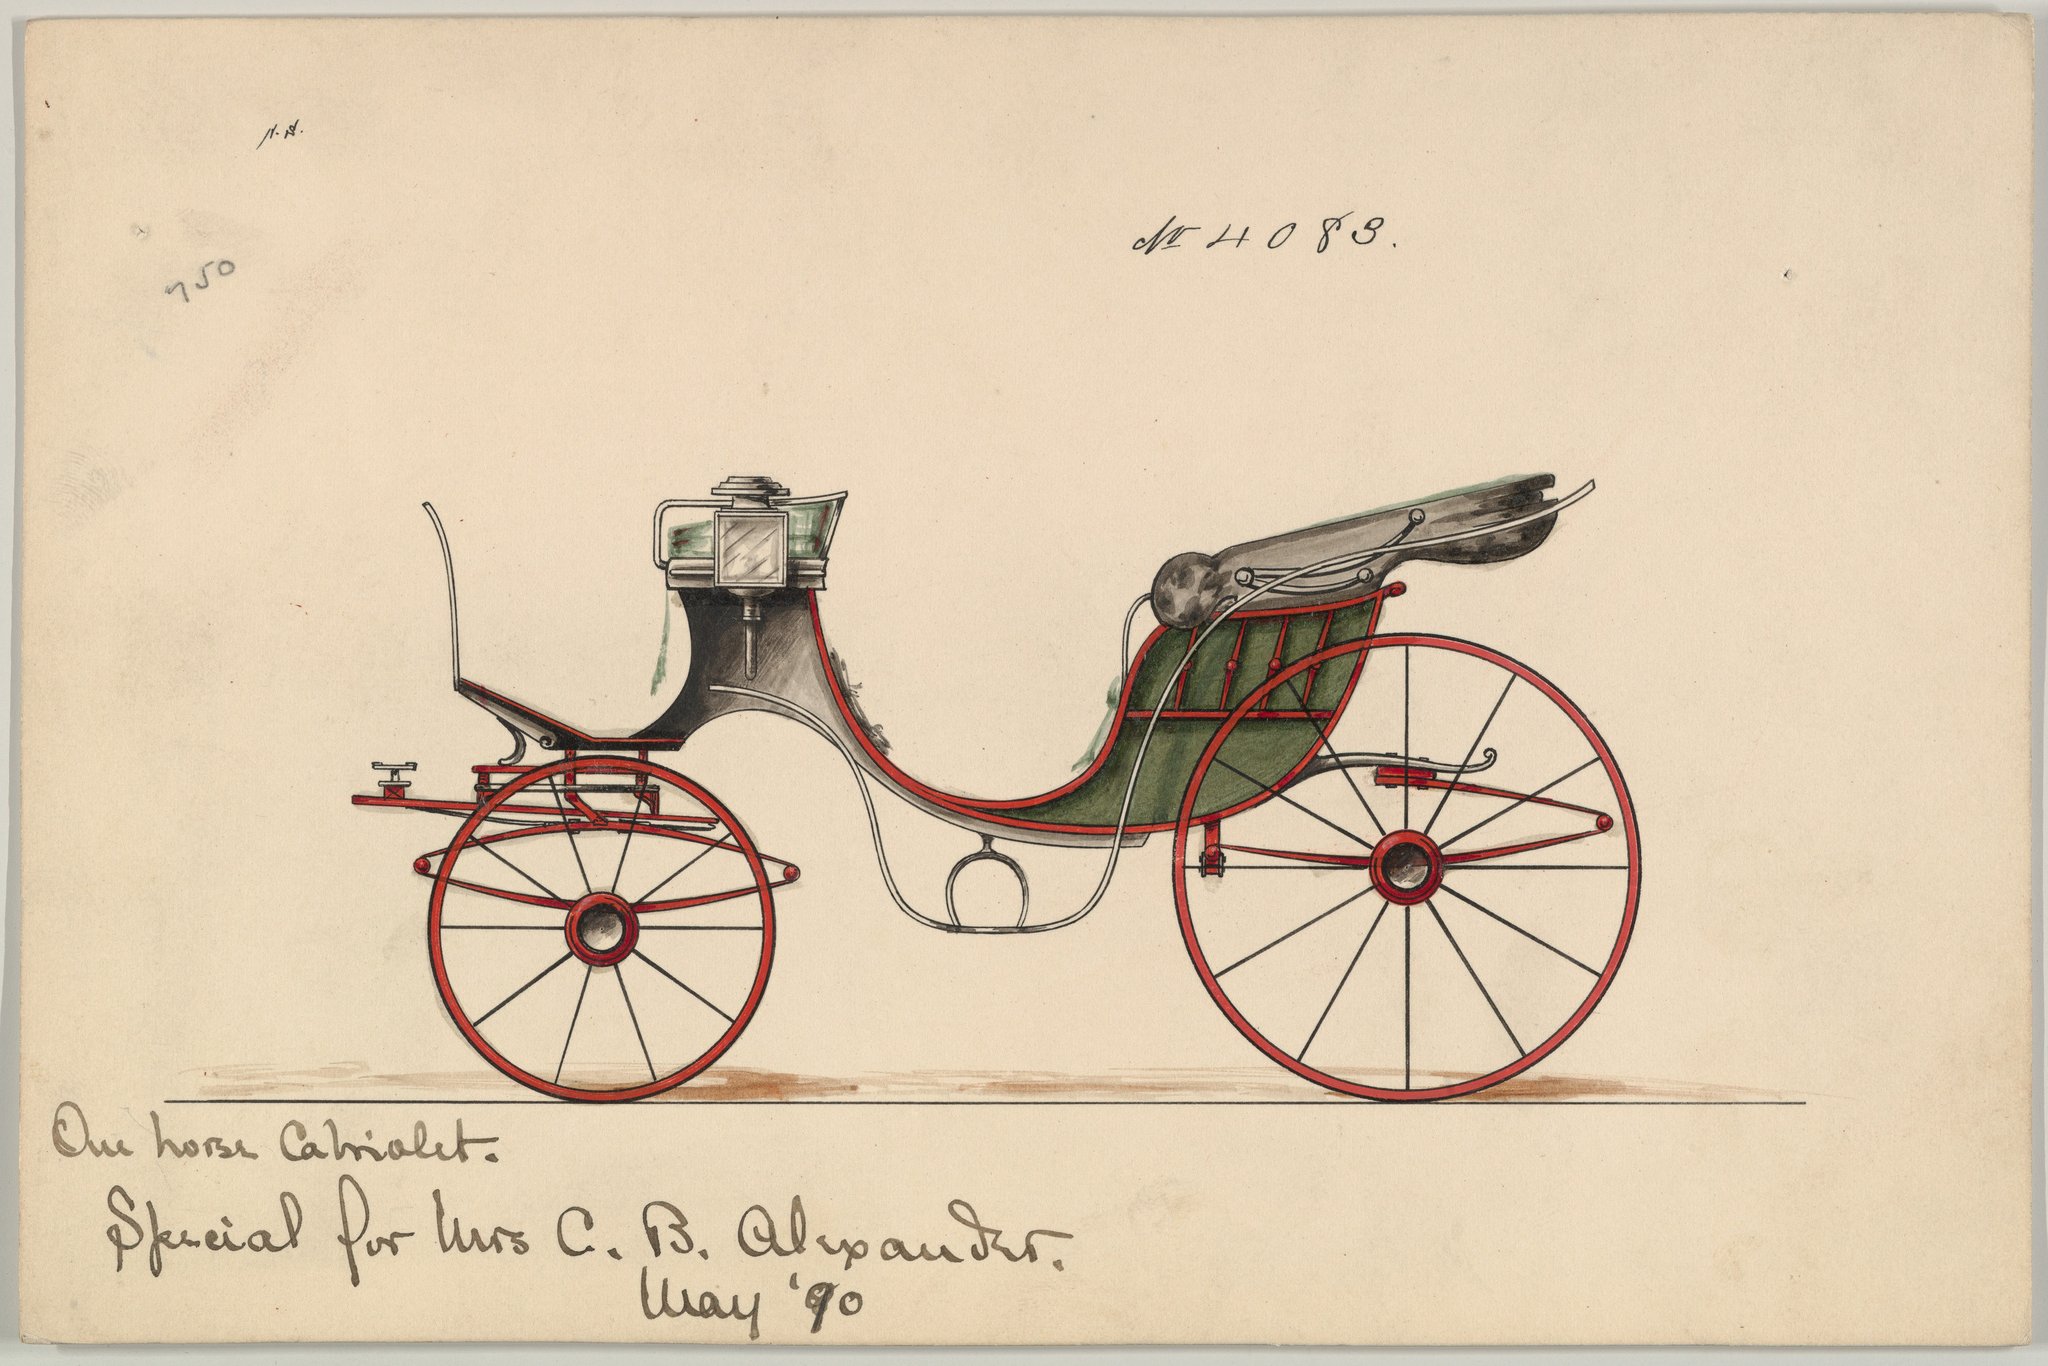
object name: drawing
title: Cabriolet #4083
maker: brewster & co.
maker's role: manufacturer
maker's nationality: american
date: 1890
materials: gouache, gum arabic, ink, watercolor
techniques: pen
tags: carriages